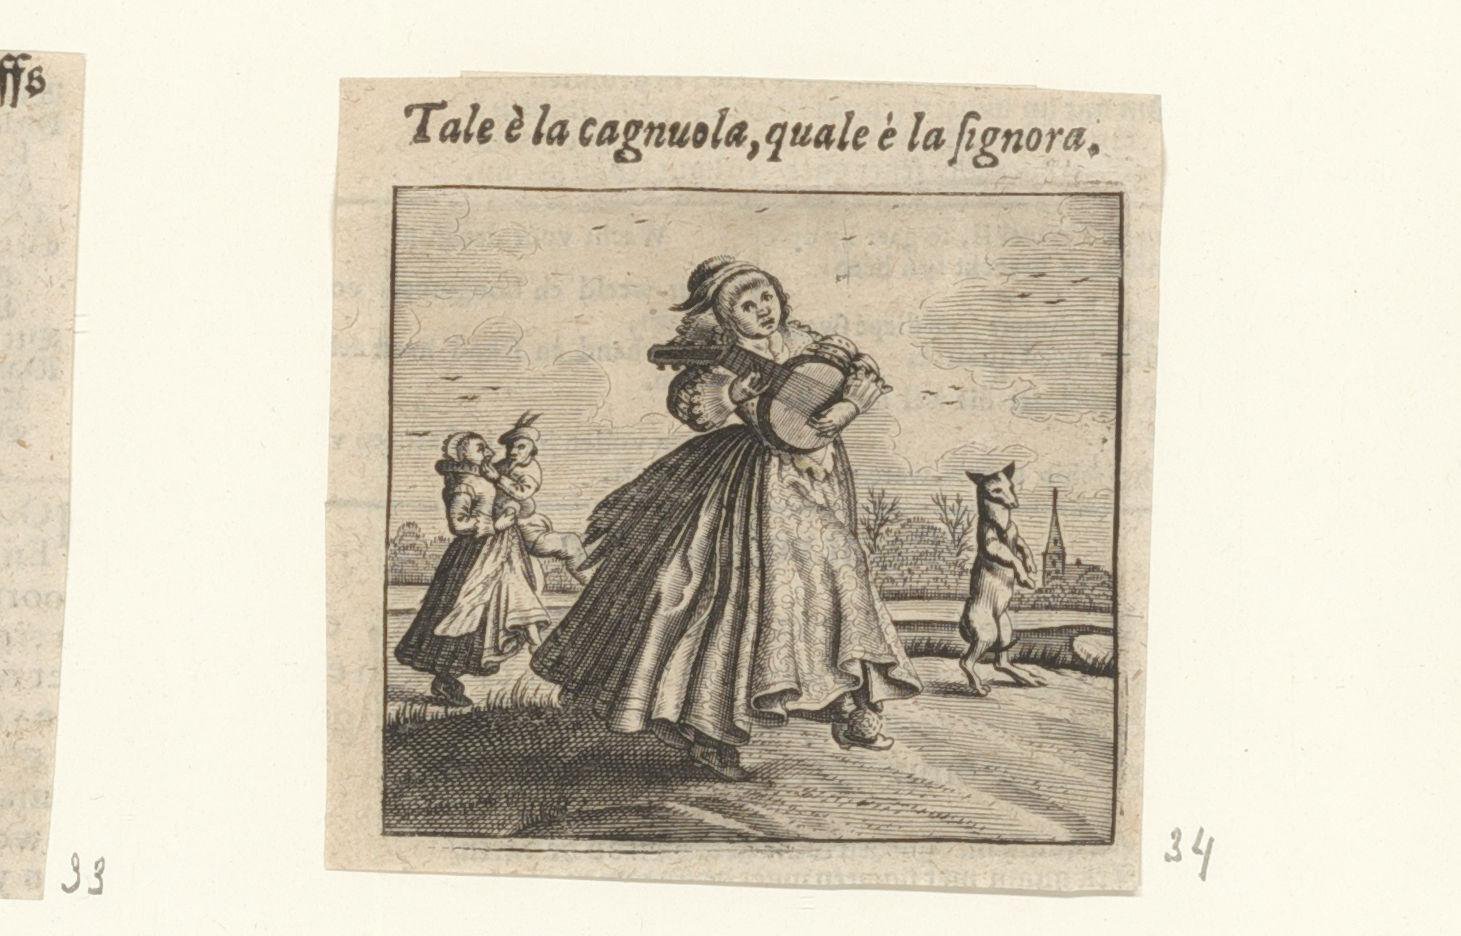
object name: book illustration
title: Vrouw bespeelt de luit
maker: Anonymous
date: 1635-1715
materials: paper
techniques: engraving, letterpress printing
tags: adolescent, young woman, maiden, proverbs, sayings, etc., lute, and special forms of lute, e.g.: theorbo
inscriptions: collector's mark: Lugt 1641, stamp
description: Veel versies van dit embleem verschenen in verschillende uitgave van Spiegel van den Ouden ende Nieuwen Tydt. Zoals: Cats, Jacob. Spiegel van den Ouden ende Nieuwen-tijt, Bestaende uyt Spreeck-woorden (...). Dordrecht: Jacob Braat, 1647. Maar ook in andere publicaties (1665, 1671, 1715, 1722).